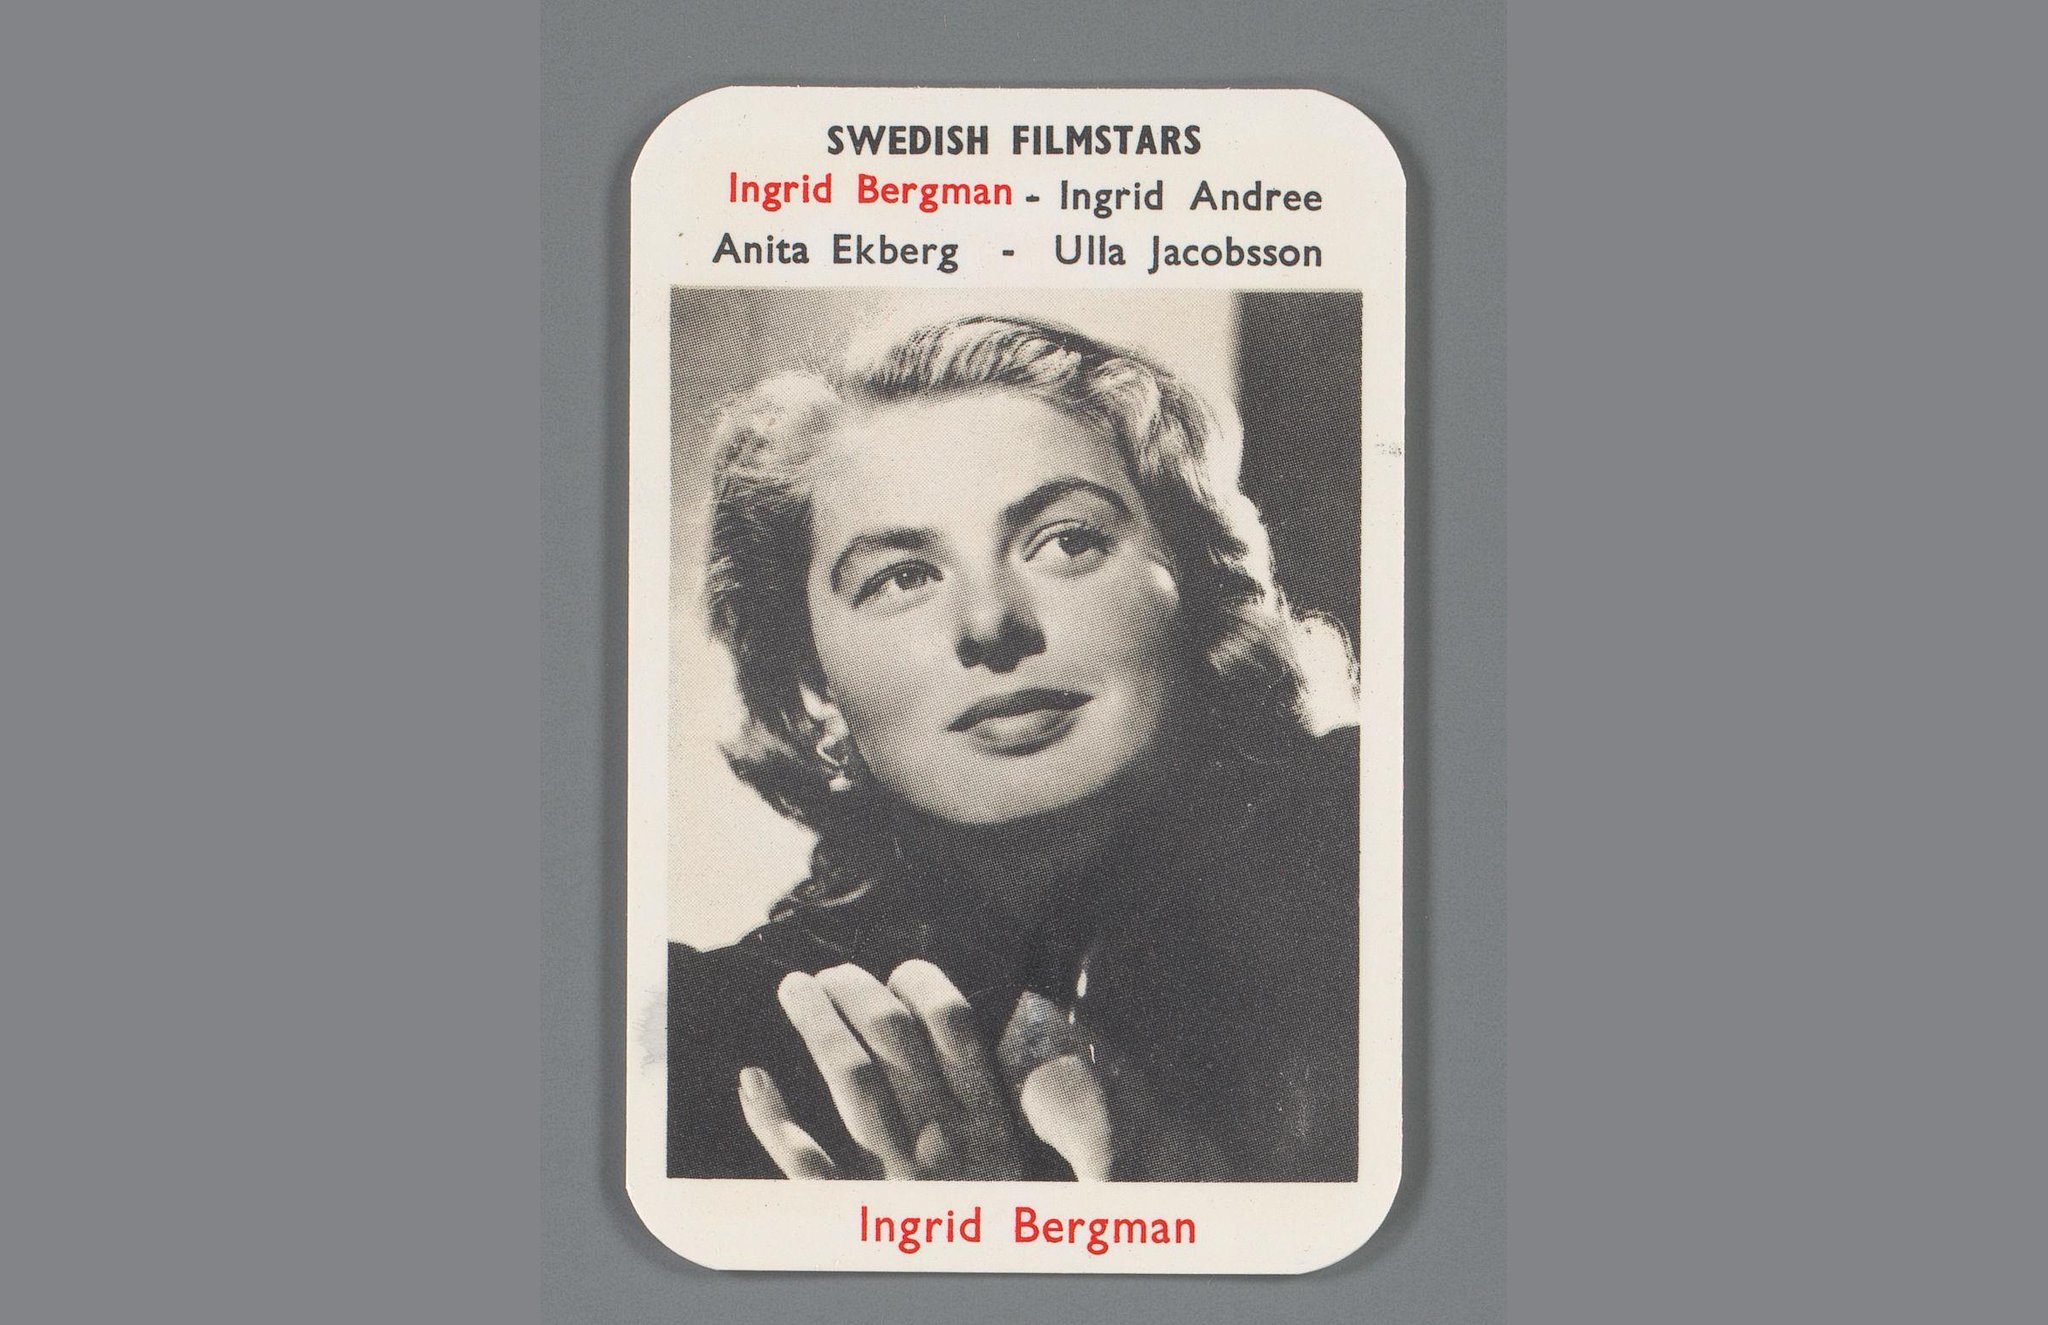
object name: photomechanical print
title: Portret van Ingrid Bergman; onderdeel van het kwartet Swedish Filmstars uit een kwartetspel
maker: Anonymous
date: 1960-1970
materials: paper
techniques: autotype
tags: london, portrait of actor, actress